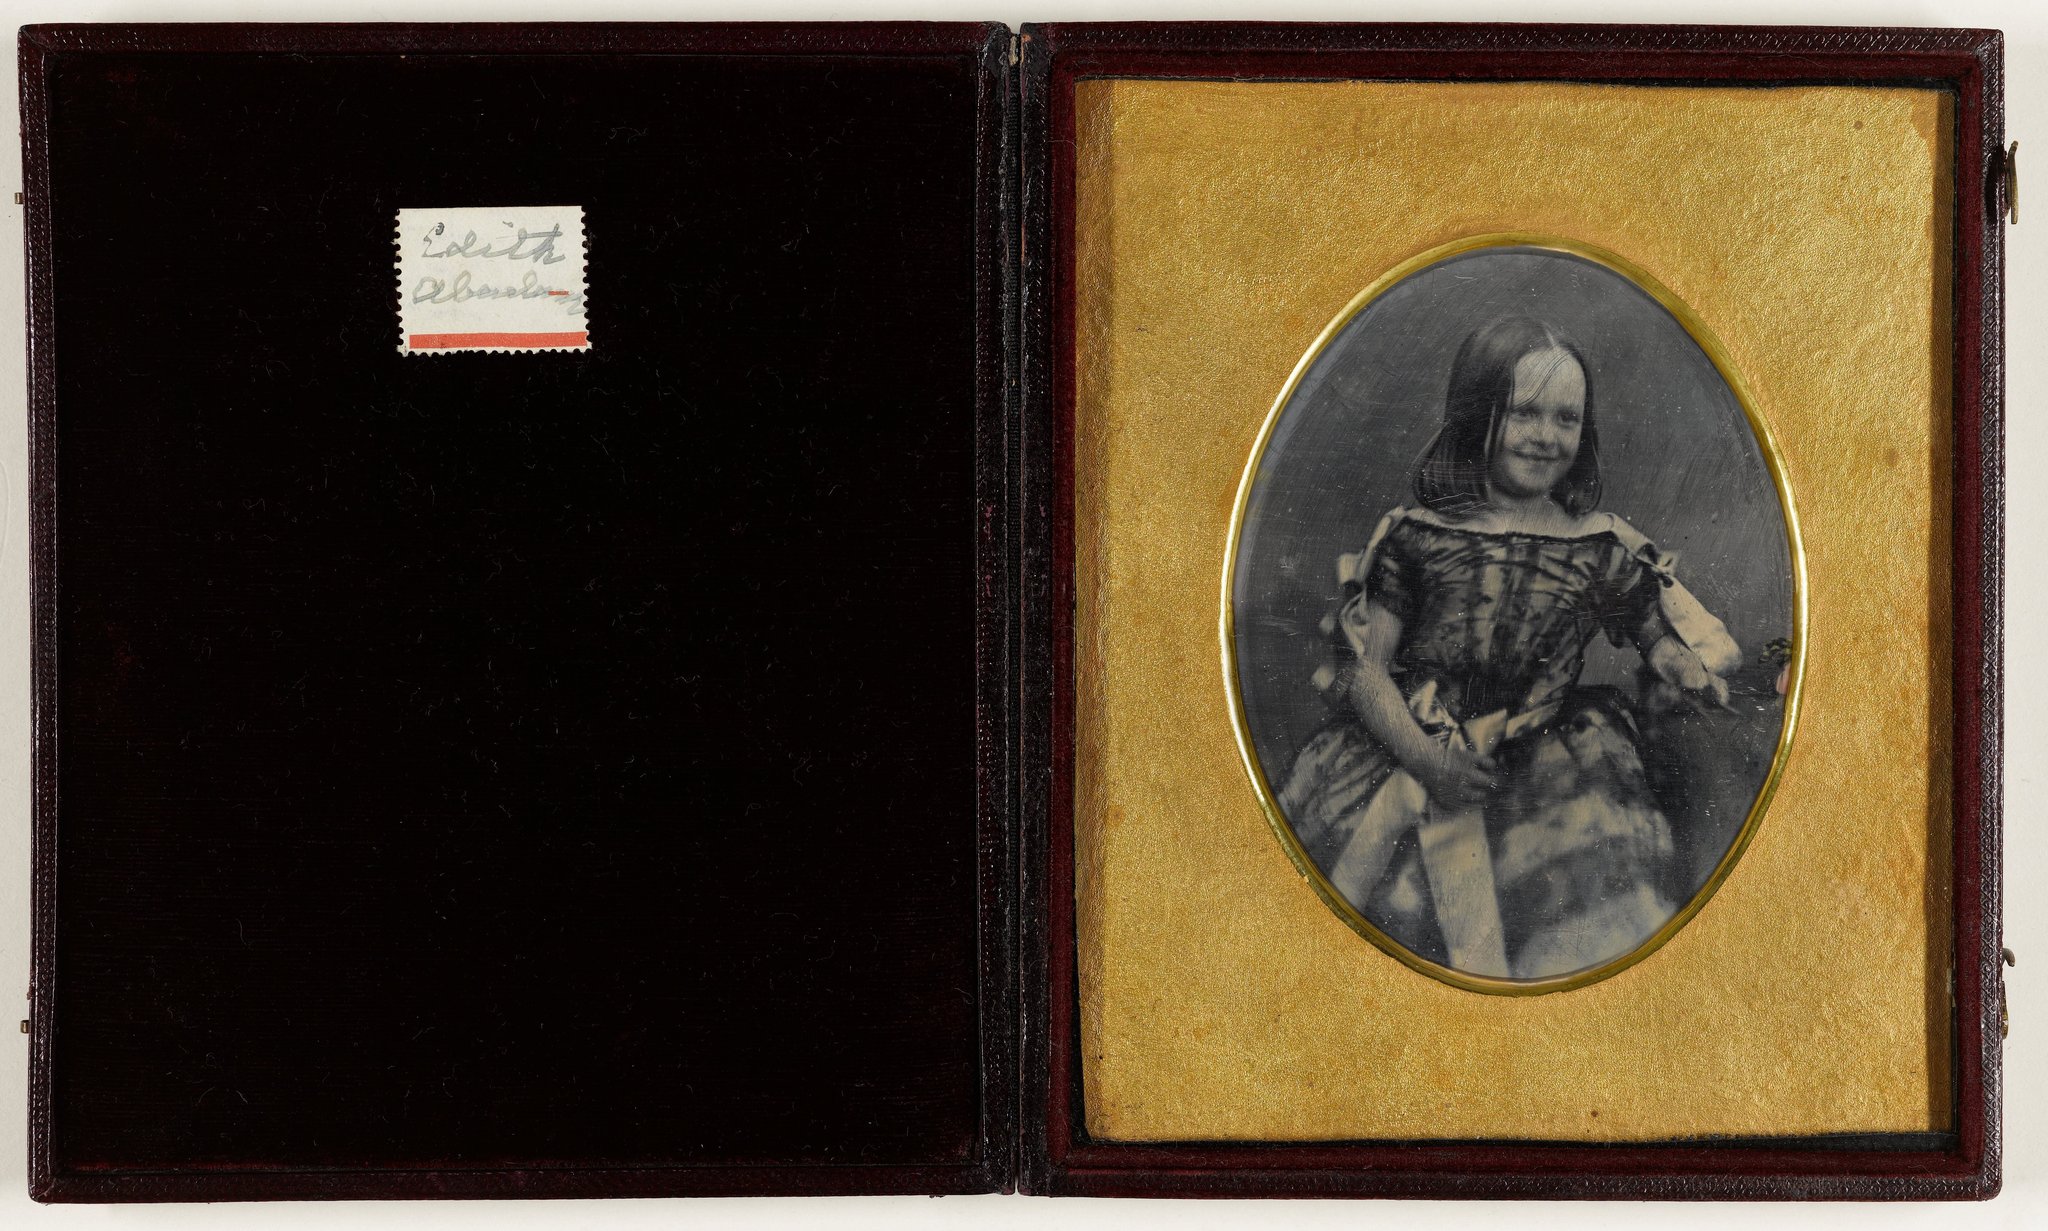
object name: photograph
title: Portret van een lachend meisje, Edith Abadam (?)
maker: john jabez edwin mayall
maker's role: fotograaf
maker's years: 1813-1901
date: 1850-1865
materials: copper, glass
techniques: daguerreotype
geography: great britain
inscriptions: annotation: ‘Edith / Abadam [?]’, stamp: ‘DAGUERREOTYPE INSTITUTION / J.E. MAYALL / 433, WEST STRAND’